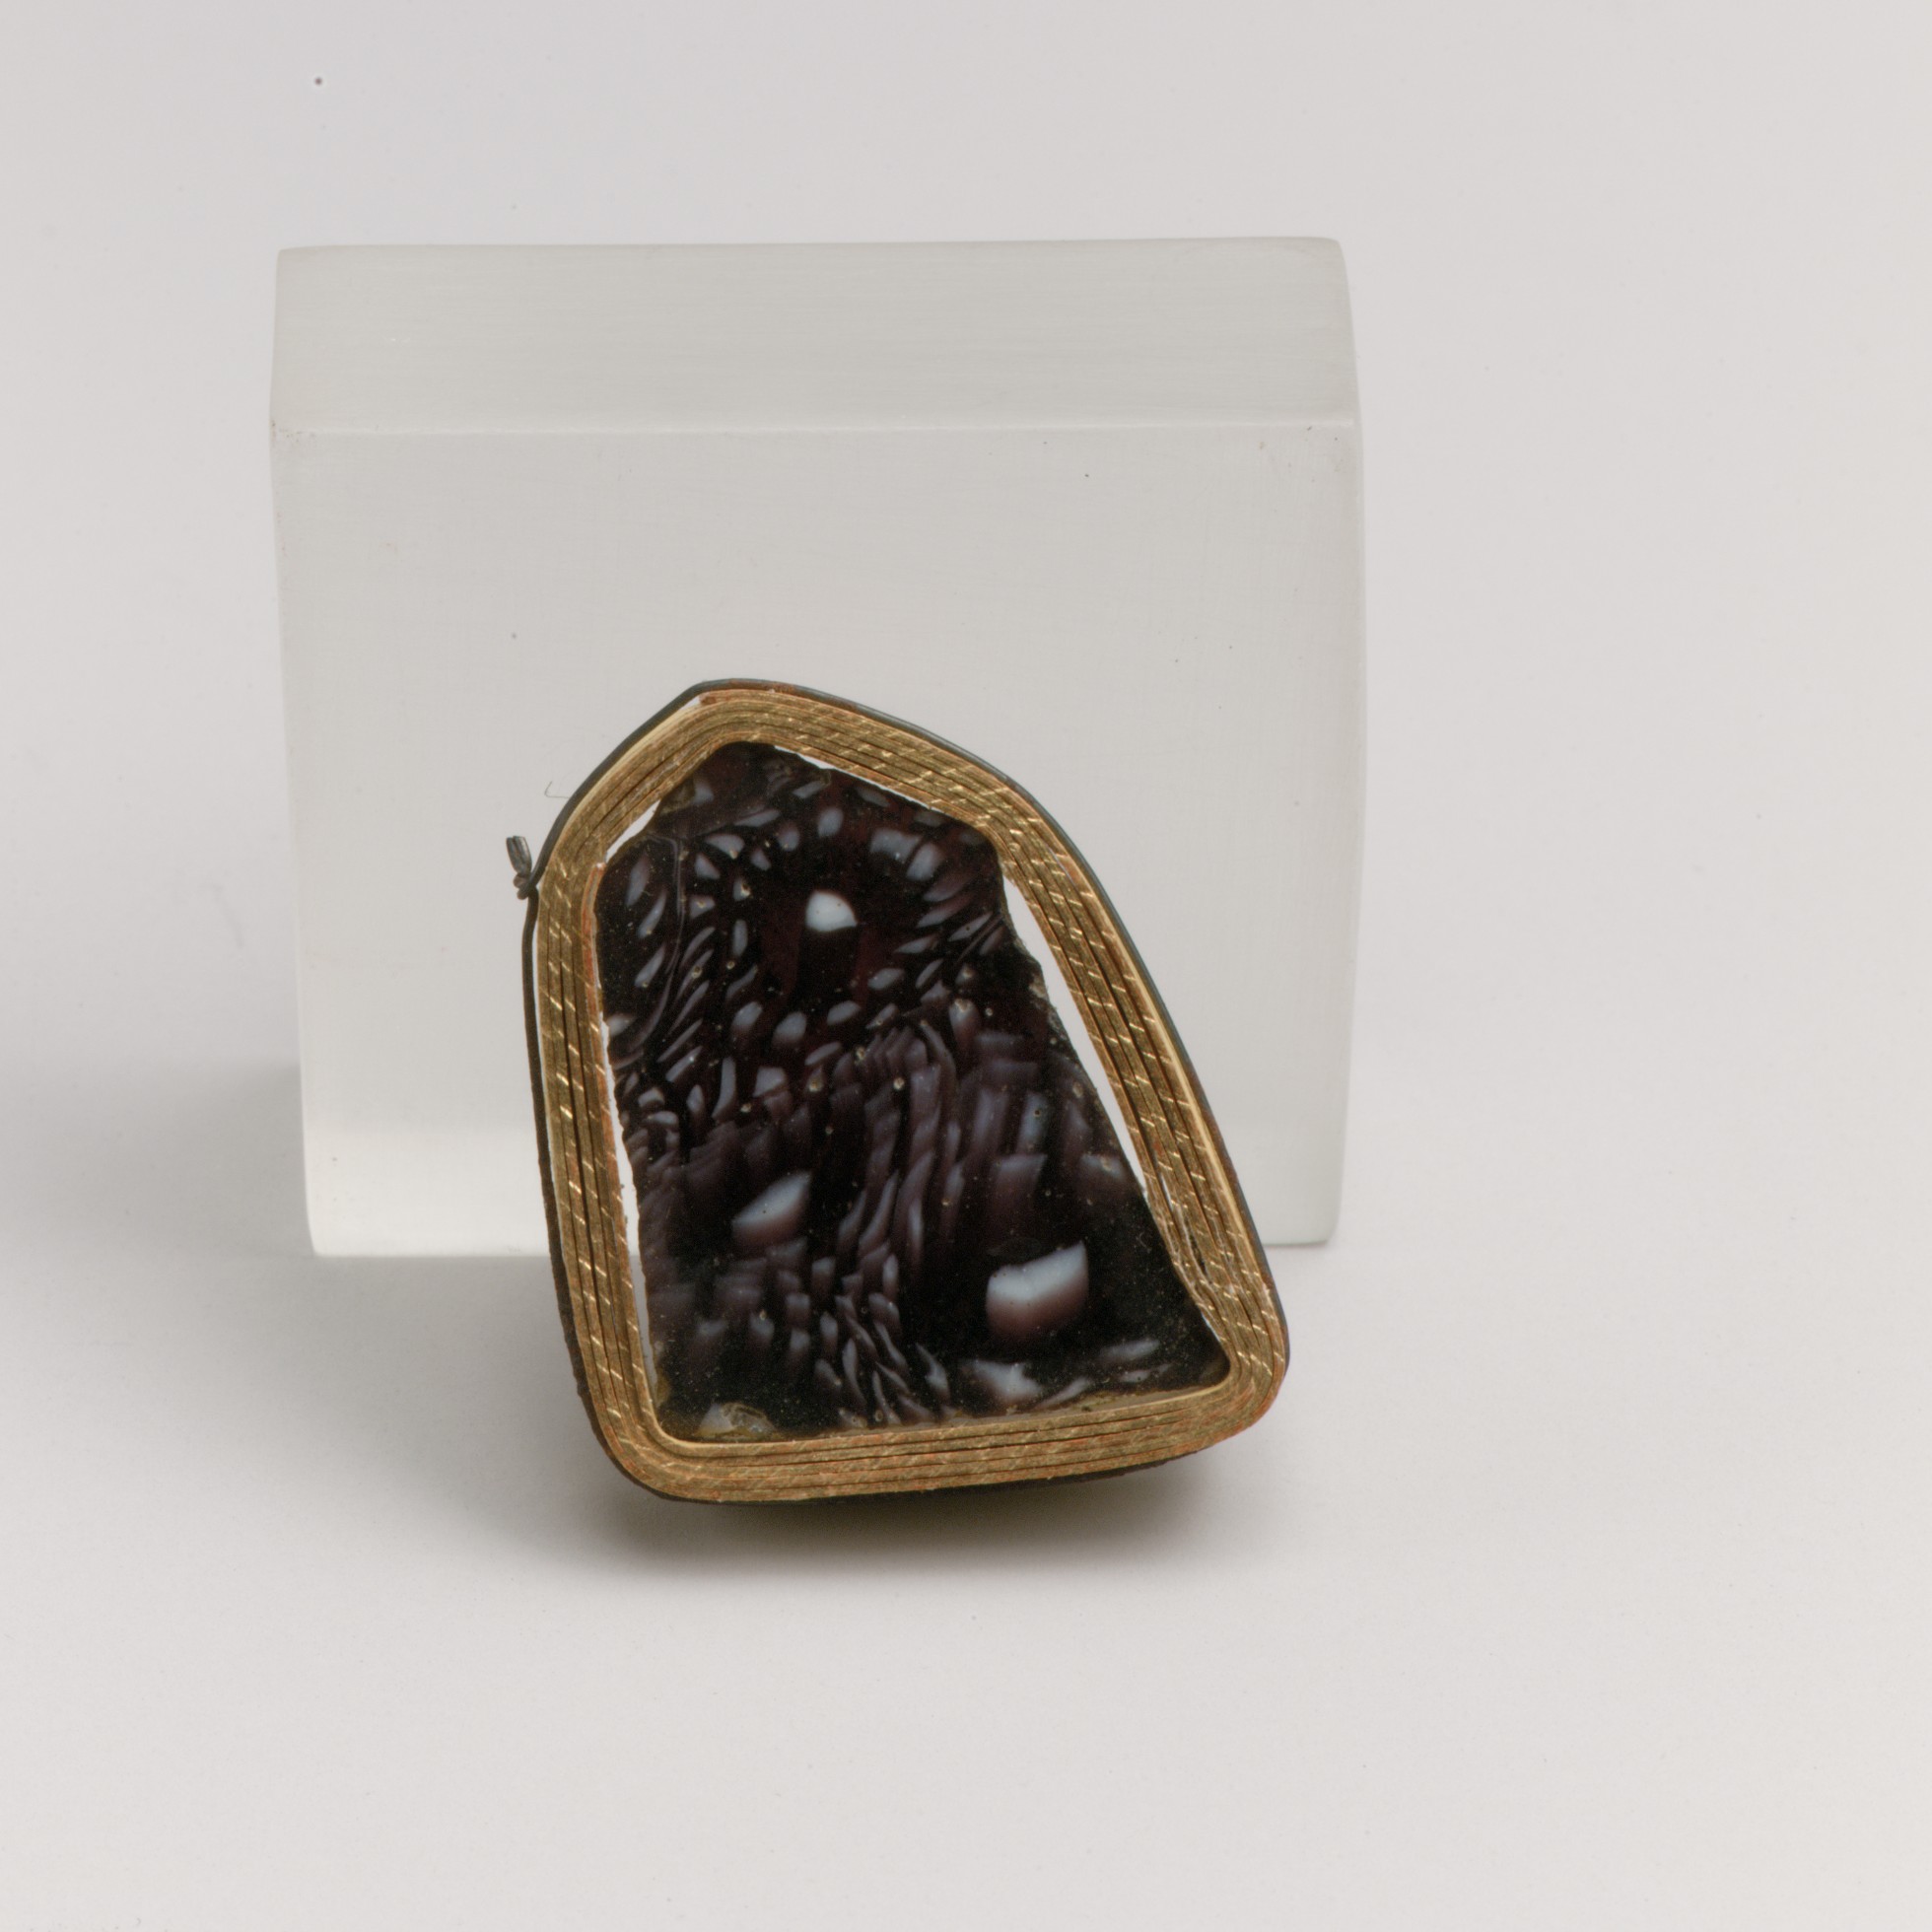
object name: fragment, mosaic bowl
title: Glass mosaic bowl fragment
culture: roman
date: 34 BCE-33 CE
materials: glass